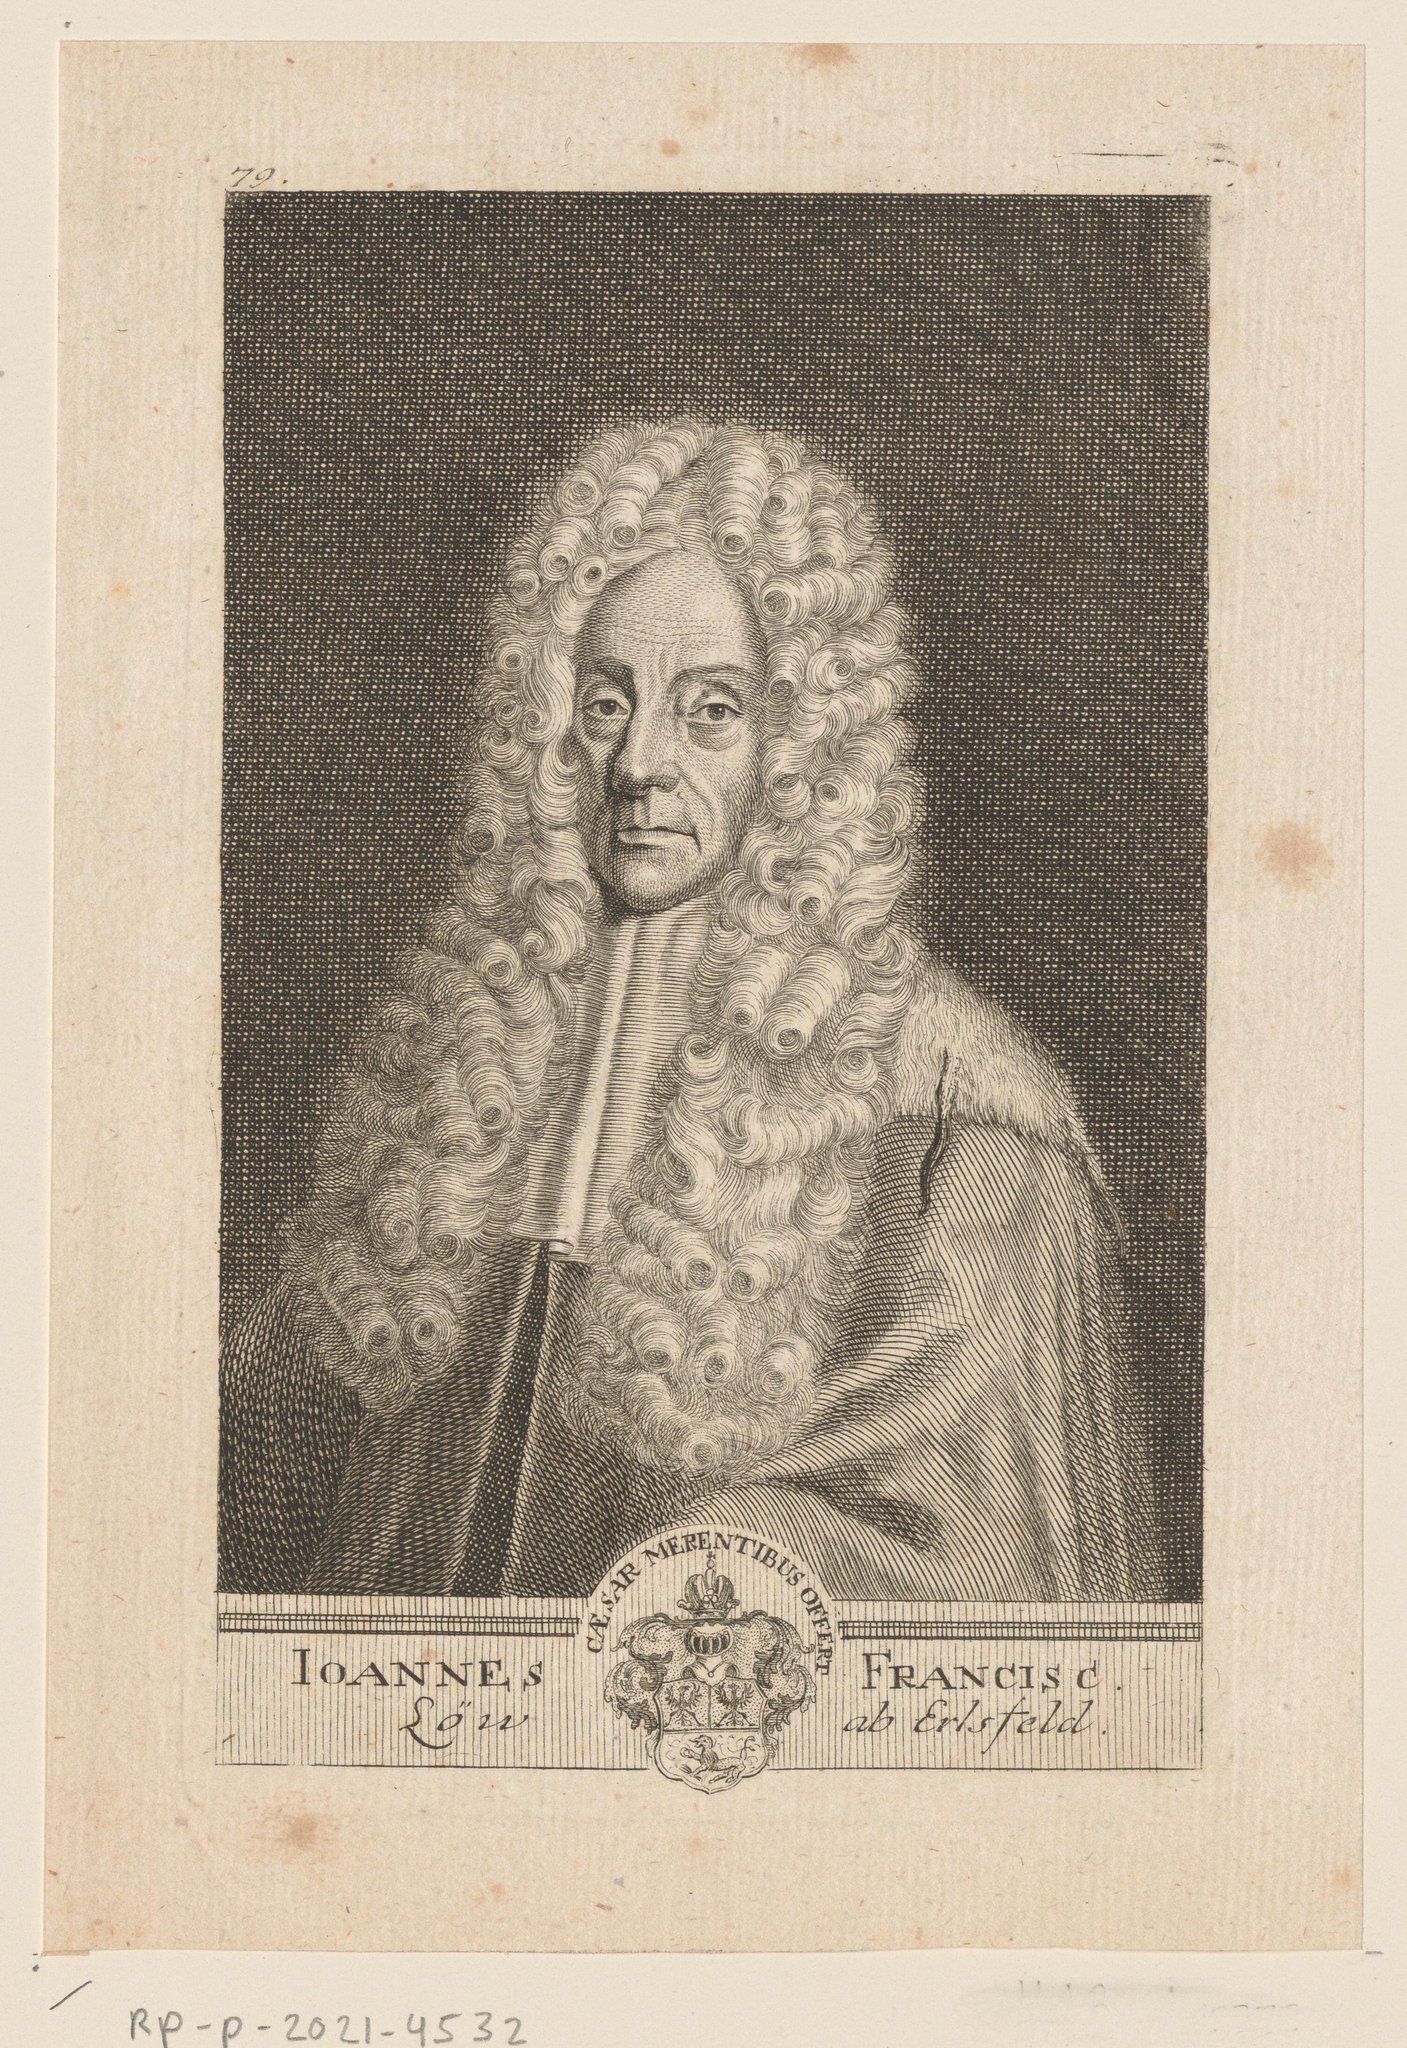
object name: print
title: Portret van Johann Franz Löw von Erlsfeld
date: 1700-1799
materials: paper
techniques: engraving, etching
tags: historical persons, armorial bearing, heraldry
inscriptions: collector's mark: Lugt 2228